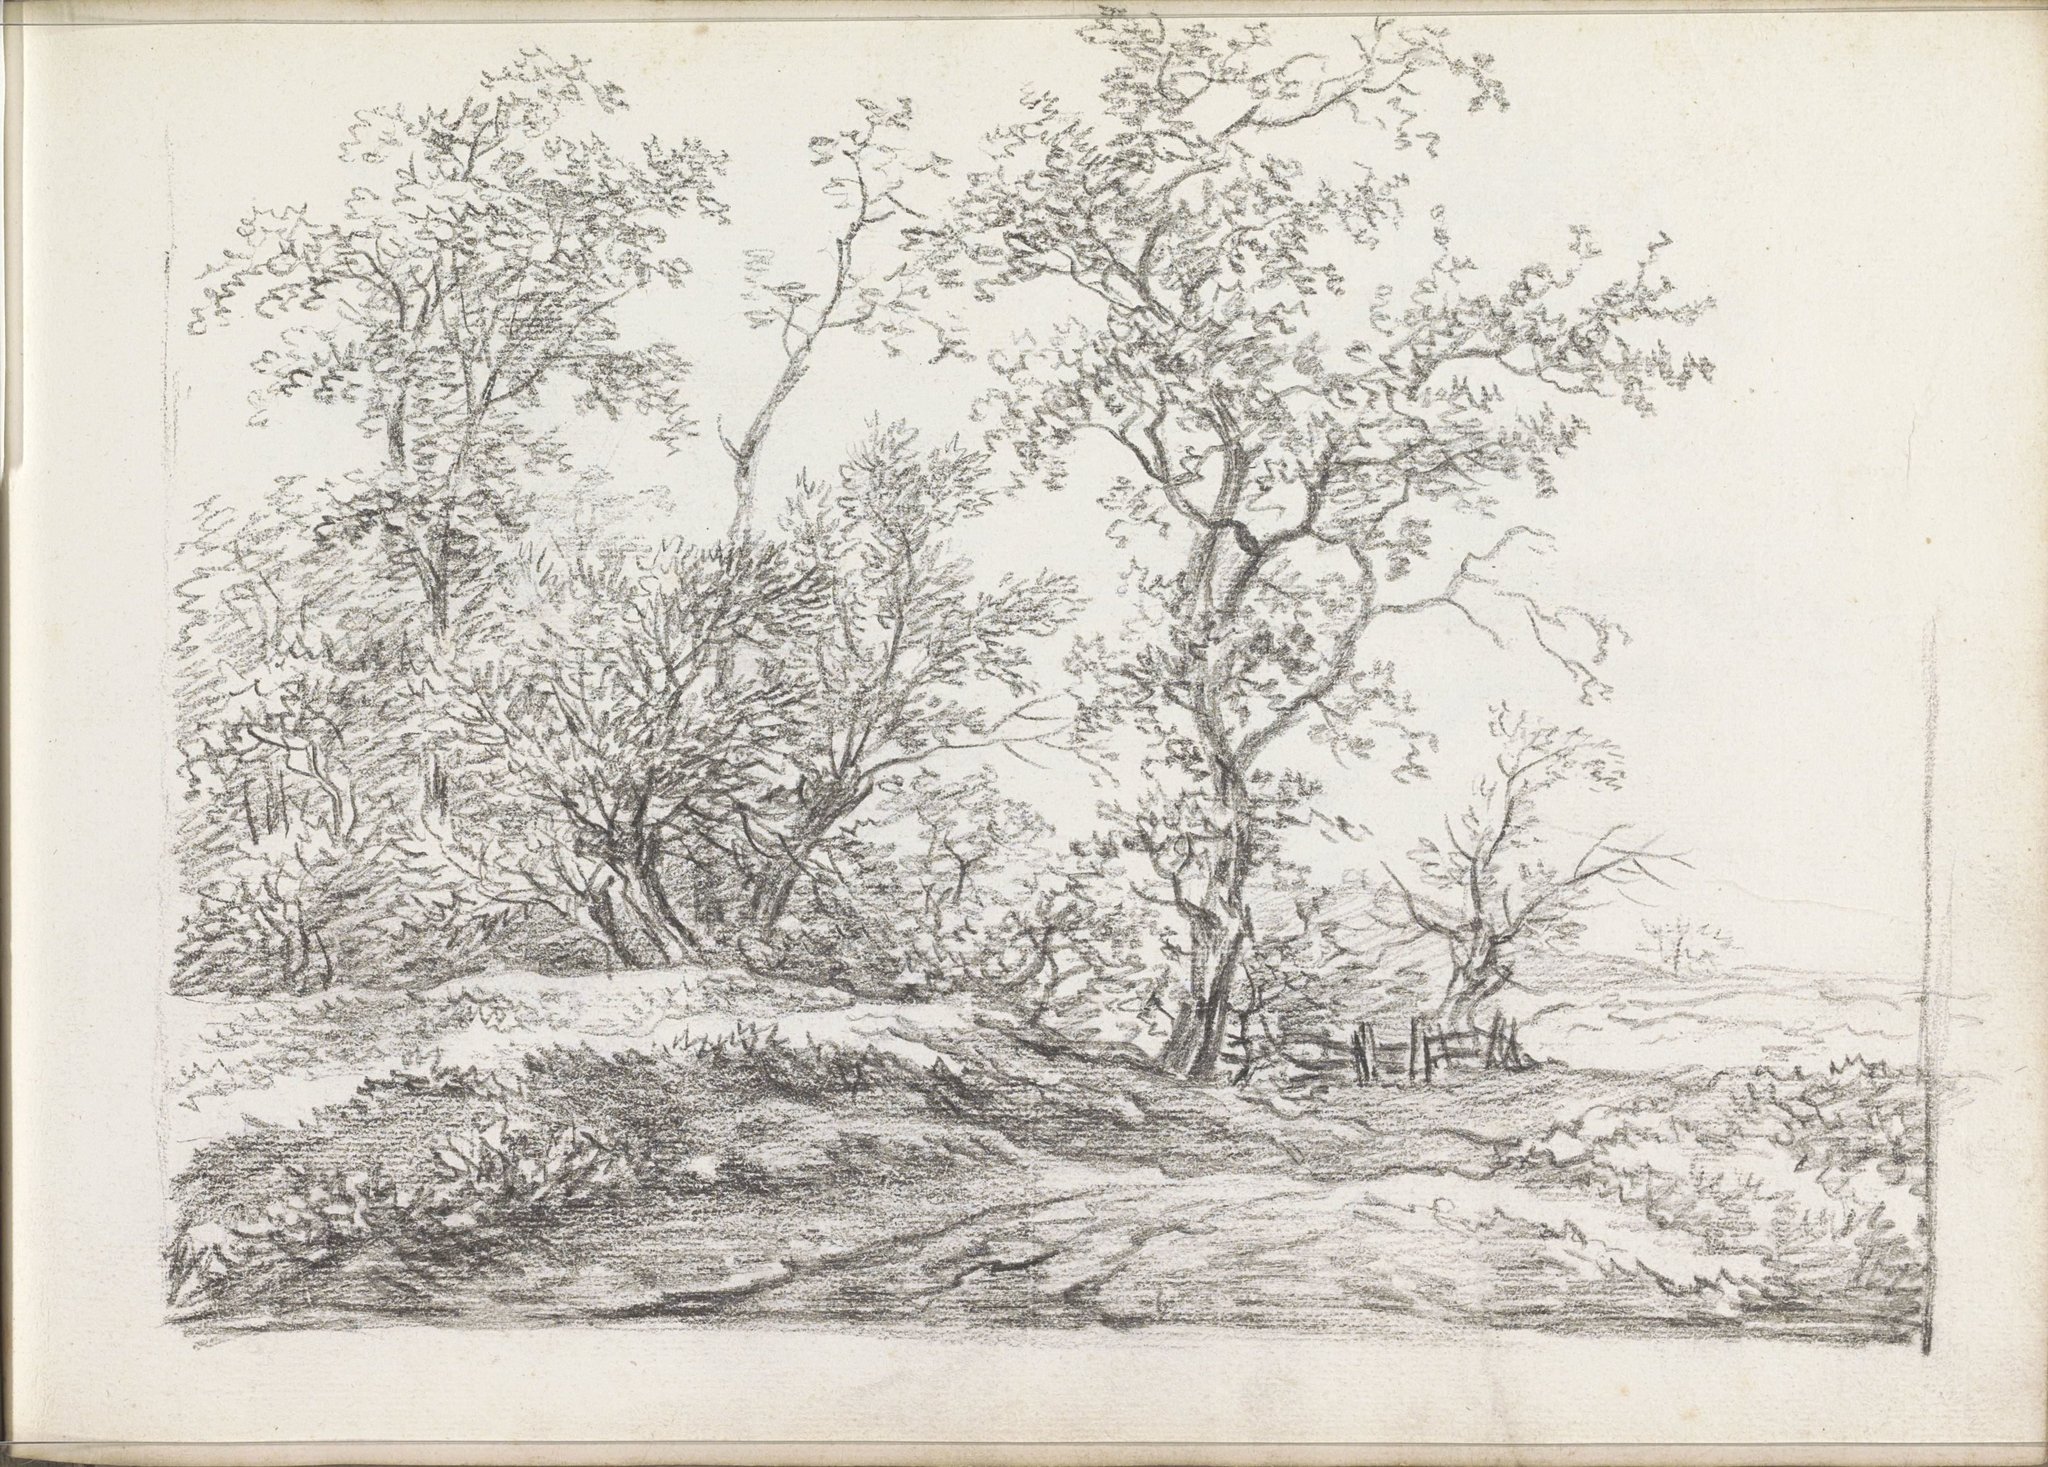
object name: sketchbook leaf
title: Landschap met bomen en een hek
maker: andreas schelfhout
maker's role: draughtsman, painter, print maker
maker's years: 1787-1870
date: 1811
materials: chalk, paper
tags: trees, landscapes, fence, wall, paling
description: Blad 50 recto uit een schetsboek met 75 bladen.